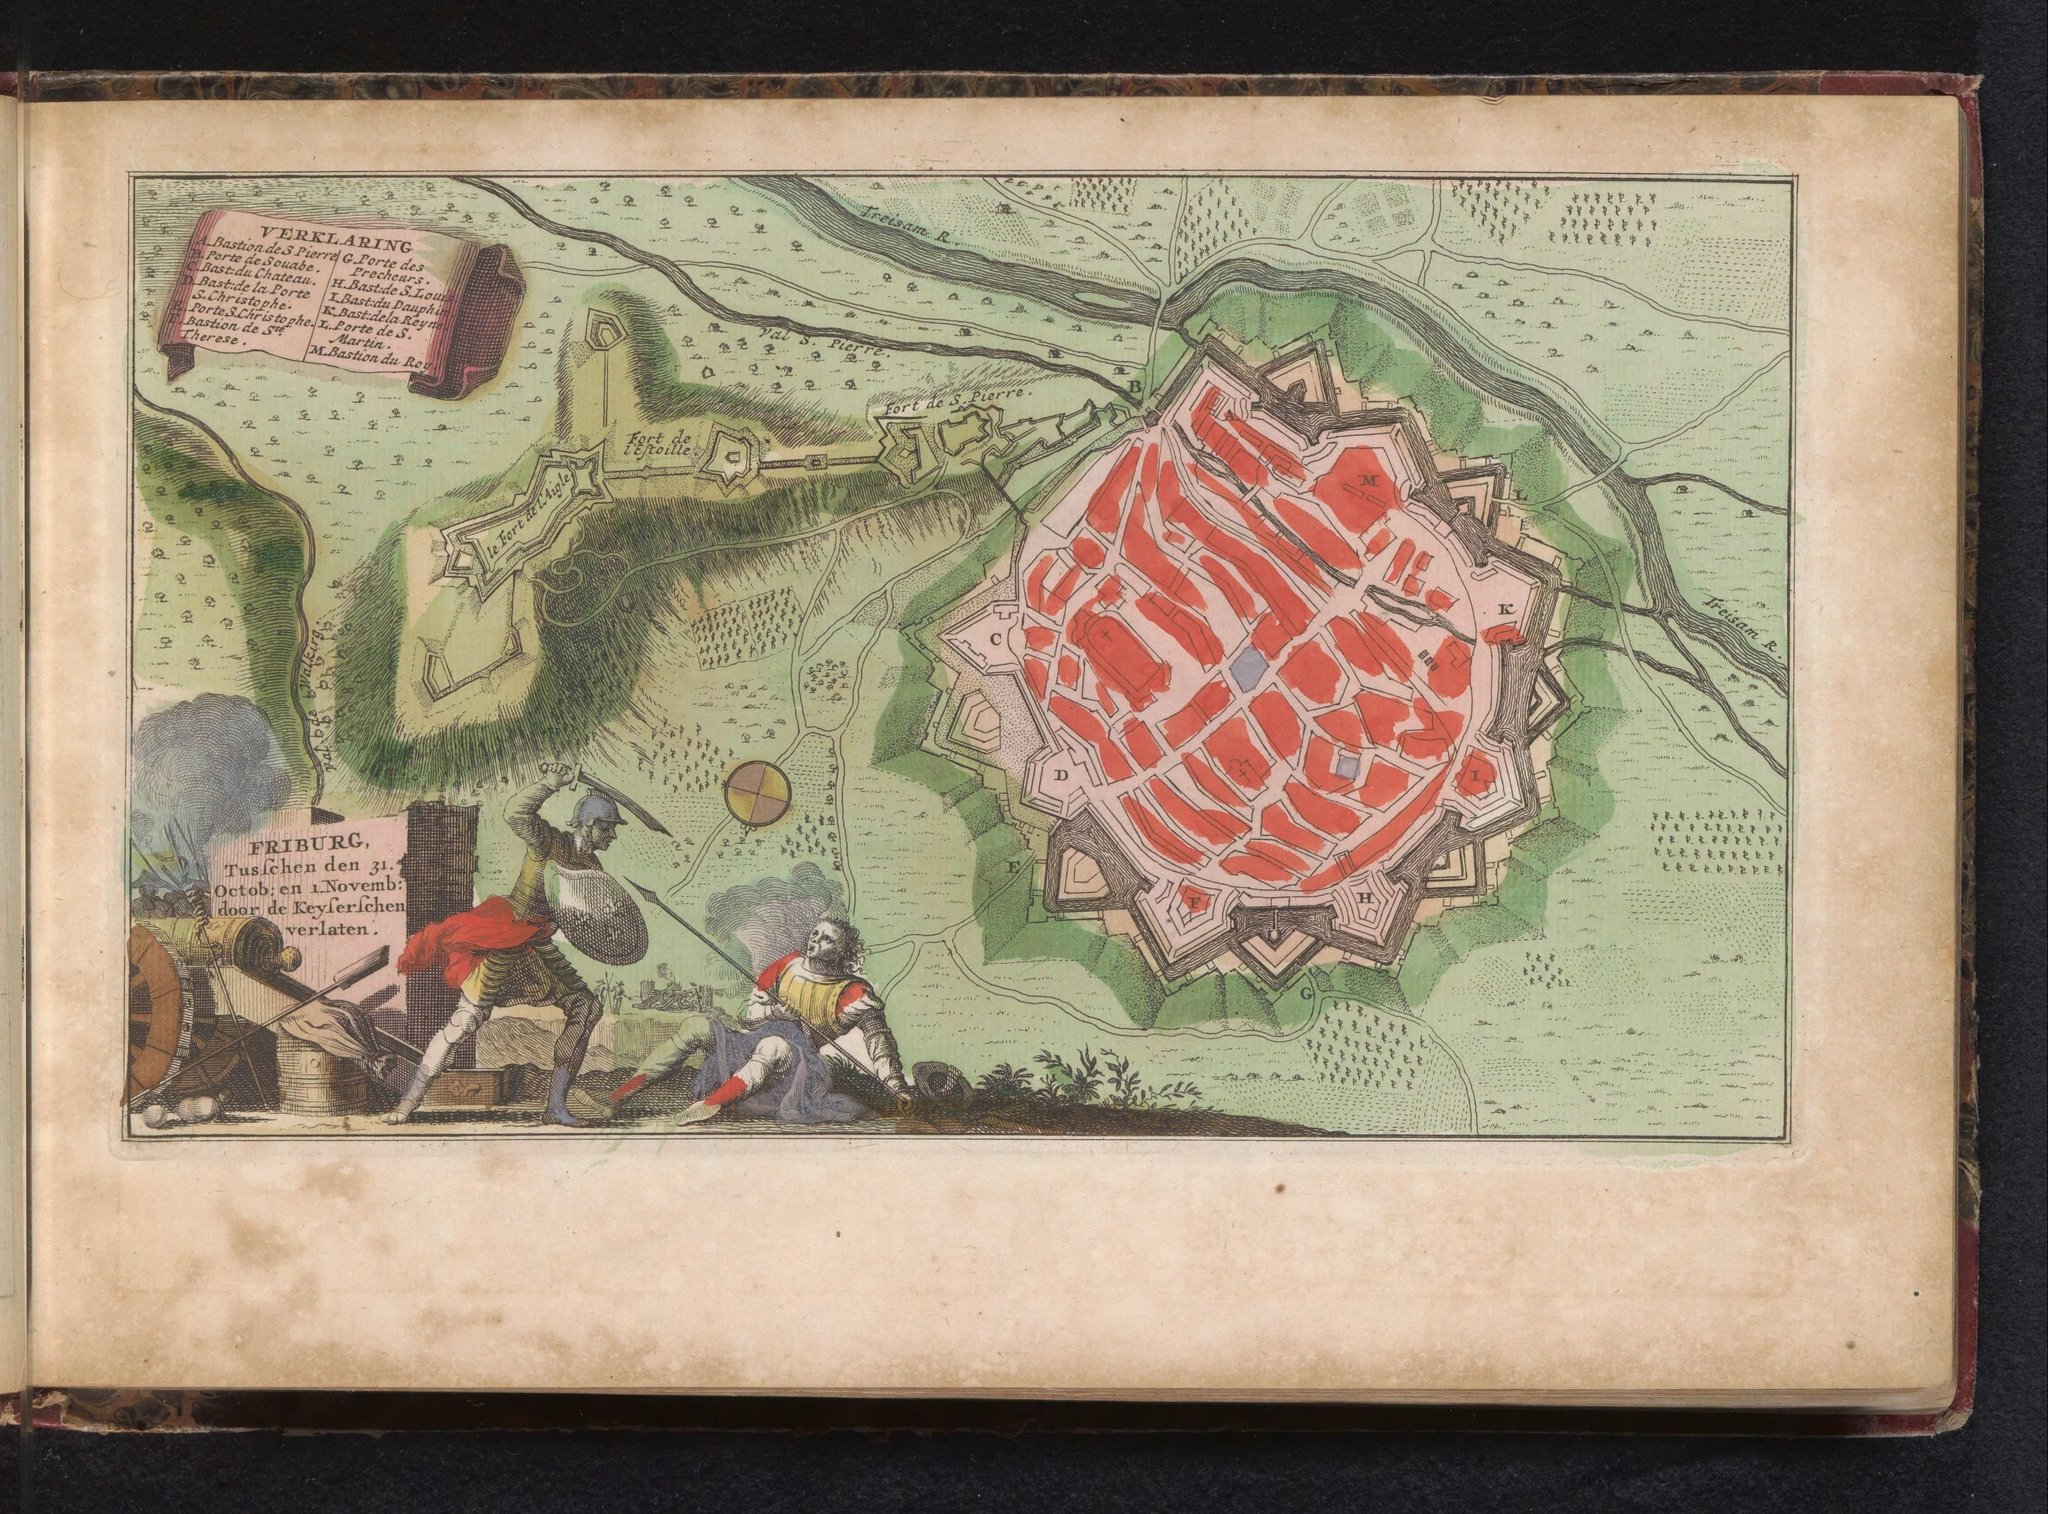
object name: map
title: Plattegrond van Freiburg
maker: Anonymous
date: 1735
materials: paper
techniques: engraving, etching, hand coloring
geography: amsterdam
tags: fortified city, maps of cities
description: Plattegrond van de versterkingen om de stad Freiburg (waarschijnlijk Freiburg im Breisgau). Linksonder overwint een Franse soldaat een op de grond zittende Oostenrijkse soldaat, linksboven de legenda A-M. Verwijst waarschijnlijk naar de inname van de stad door de Fransen op 16 november 1713. Onderdeel van een atlas met 223 kaarten van landen en steden en oorlogstaferelen in Europa in de periode ca. 1690-1735.